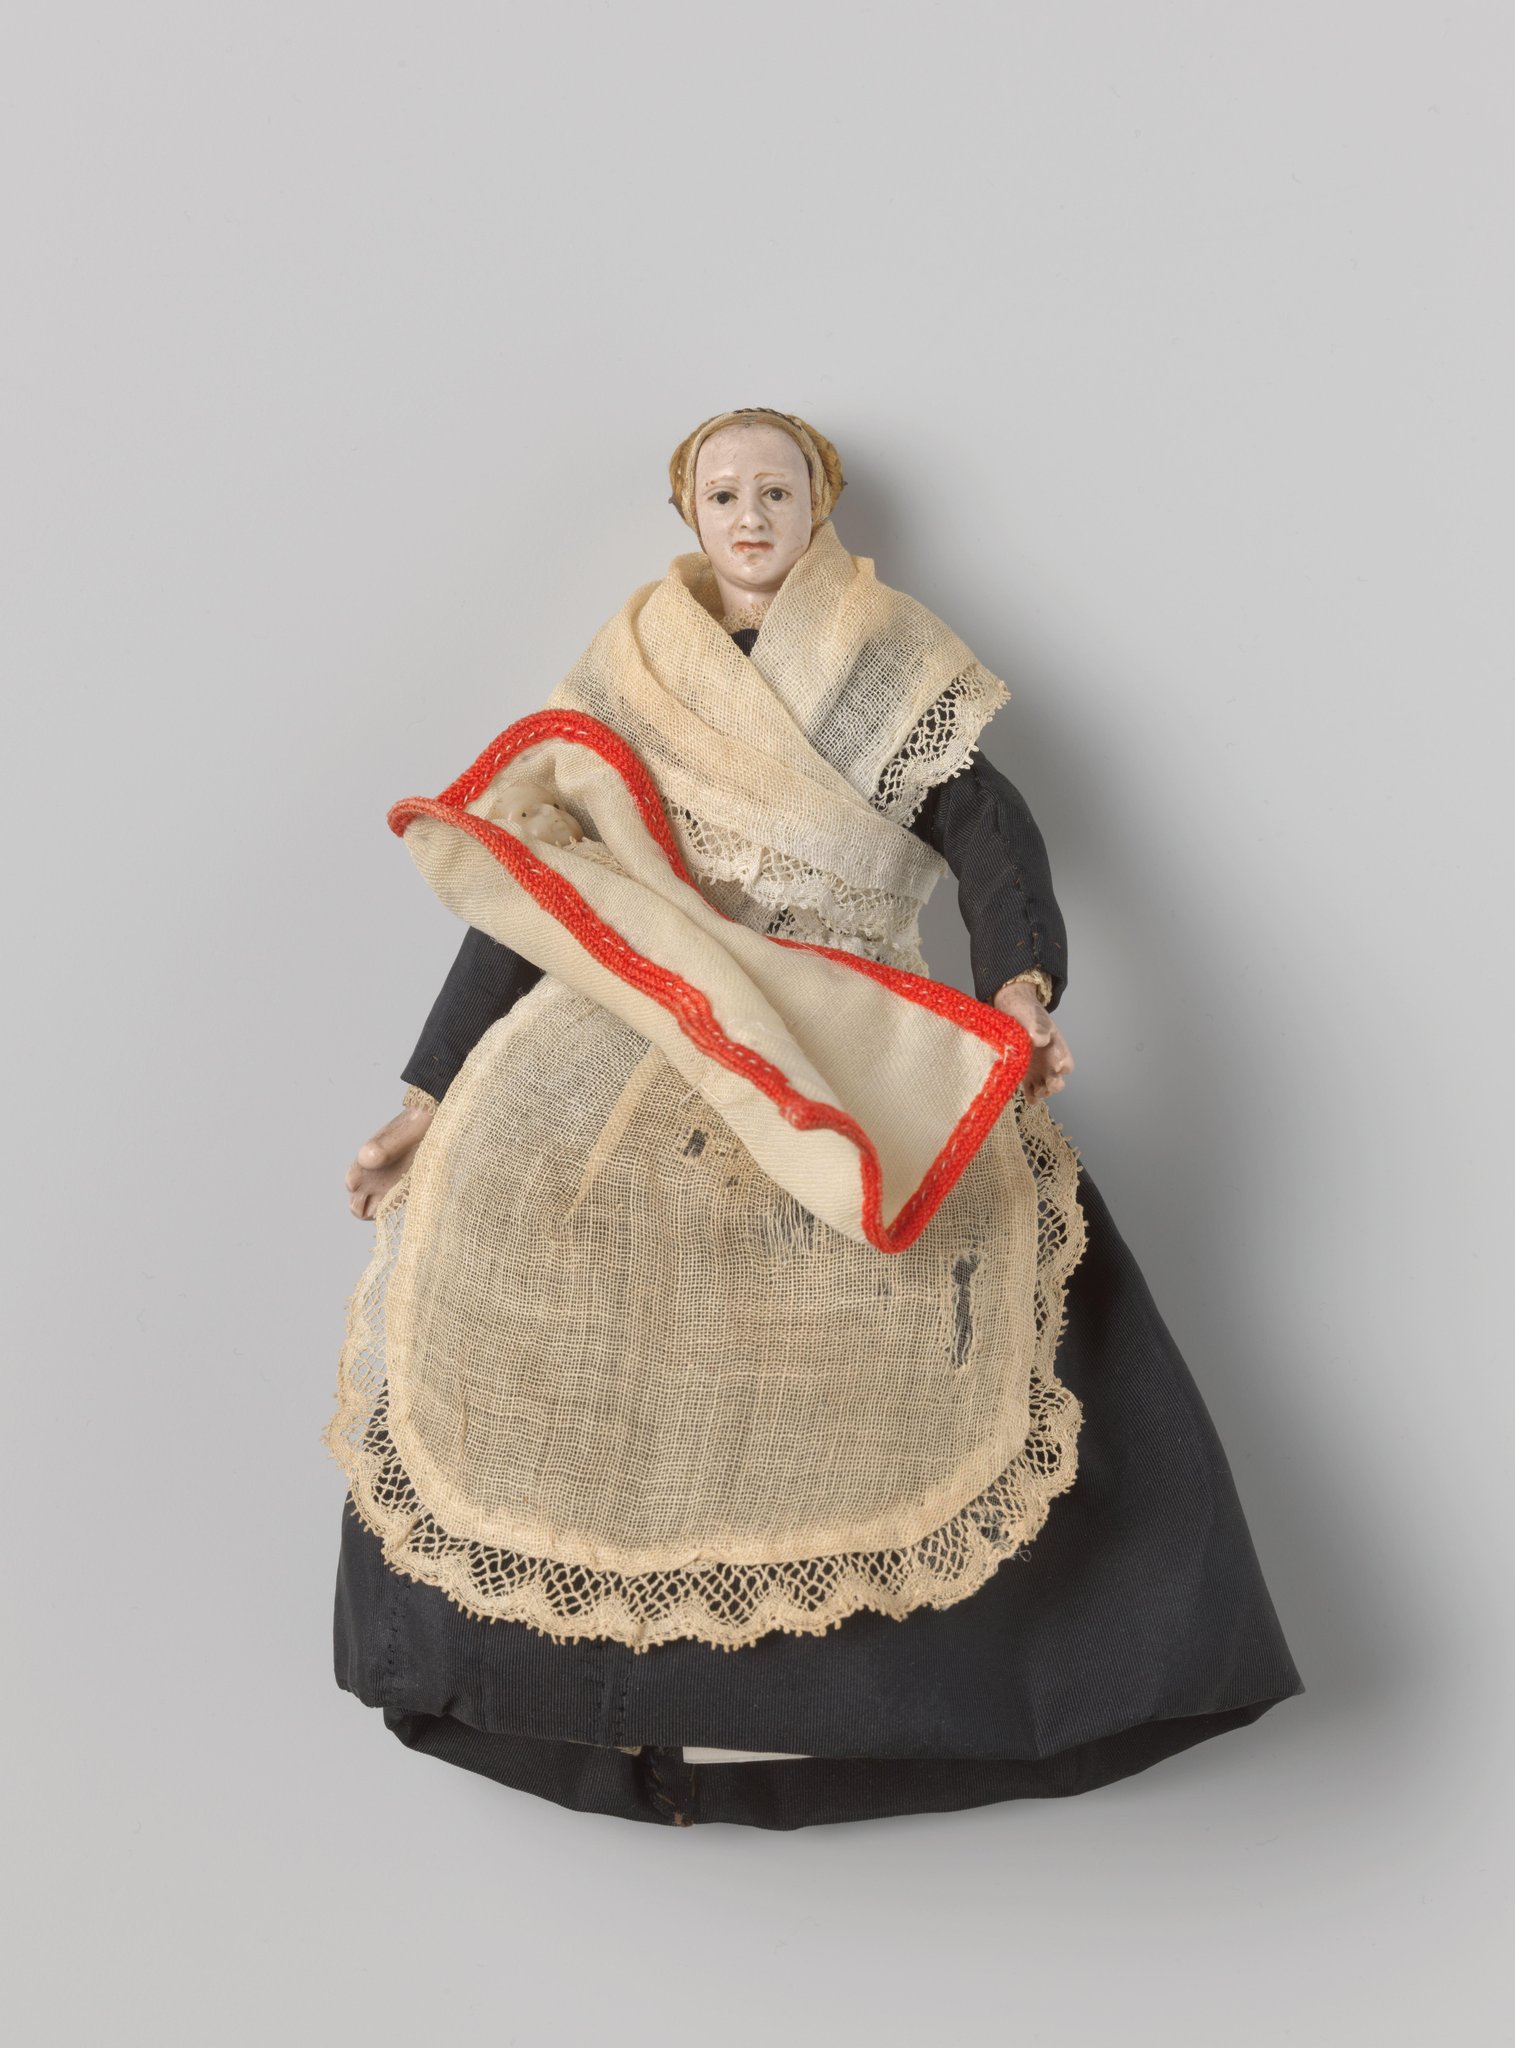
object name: doll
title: Pop, voorstellende een baker of een kindermeisje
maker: Anonymous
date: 1675-1700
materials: cotton, glass, linen, metal thread, silk, fiber, wax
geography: amsterdam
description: Pop, voorstellende een baker of een kindermeisje, vervaardigd van metaaldraad en mattenbies. Hoofd en handen van was.